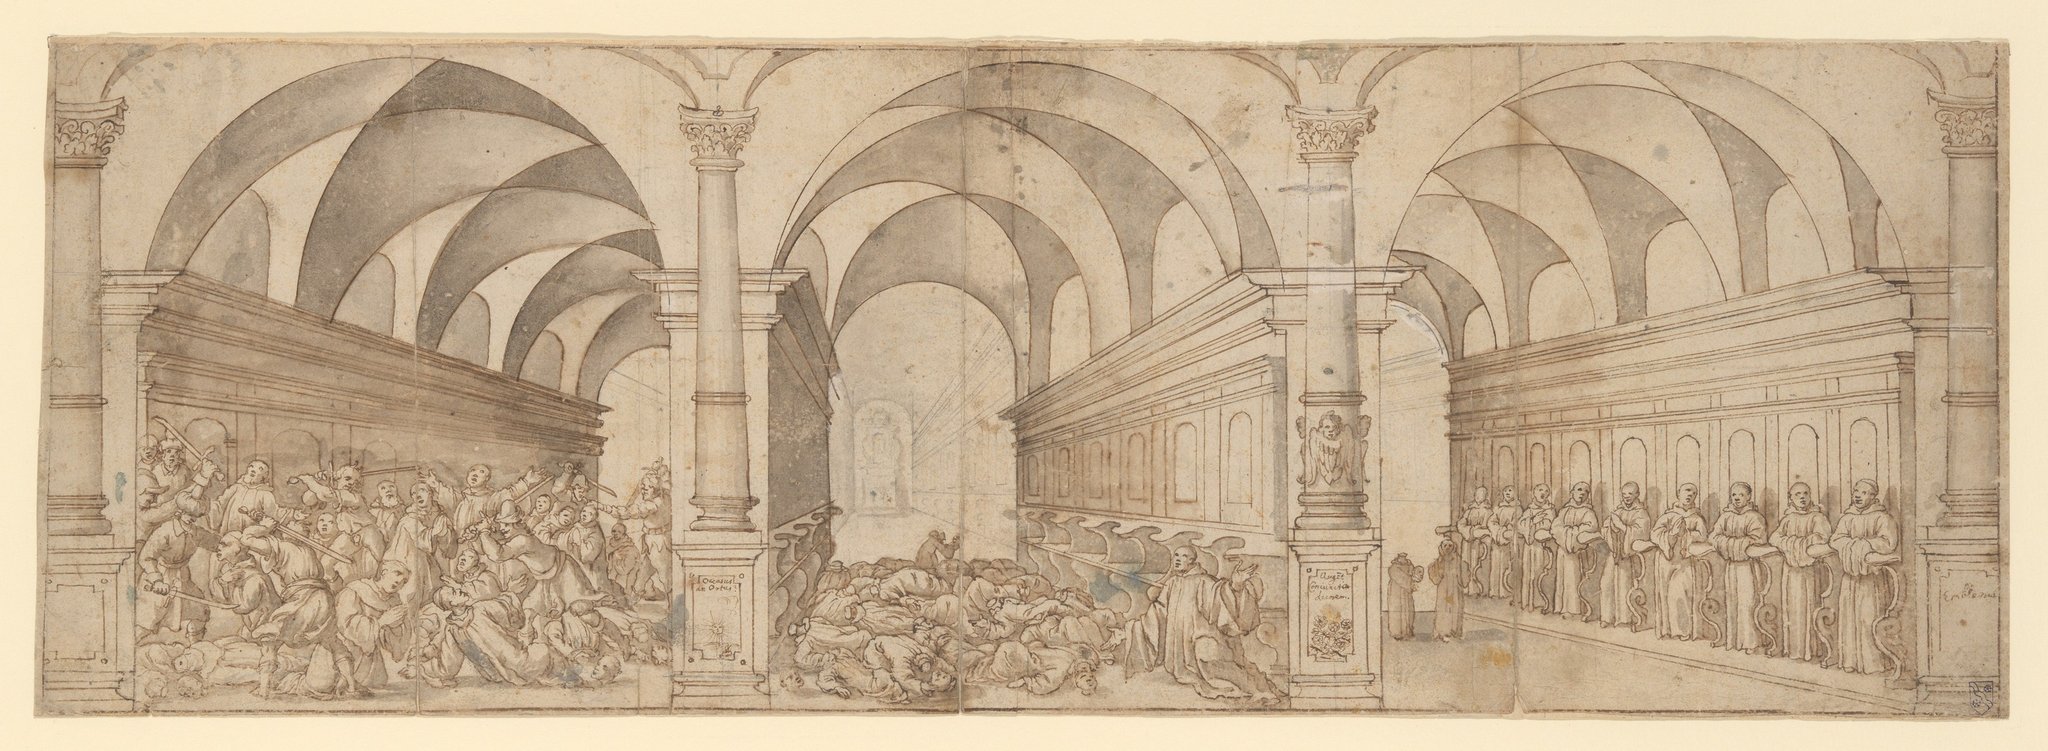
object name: drawing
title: Three Scenes of the Assassination of Clerics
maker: augustin braun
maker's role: artist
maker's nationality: german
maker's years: 1570-1639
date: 1567-1666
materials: graphite, ink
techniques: brush, pen, wash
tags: massacres,monks